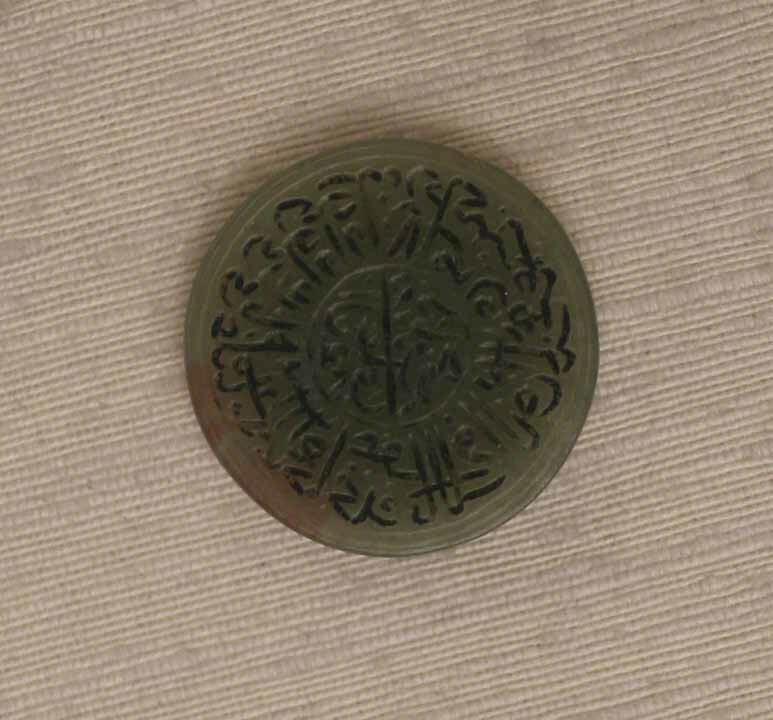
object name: seal stone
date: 1467-1533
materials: jade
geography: iran